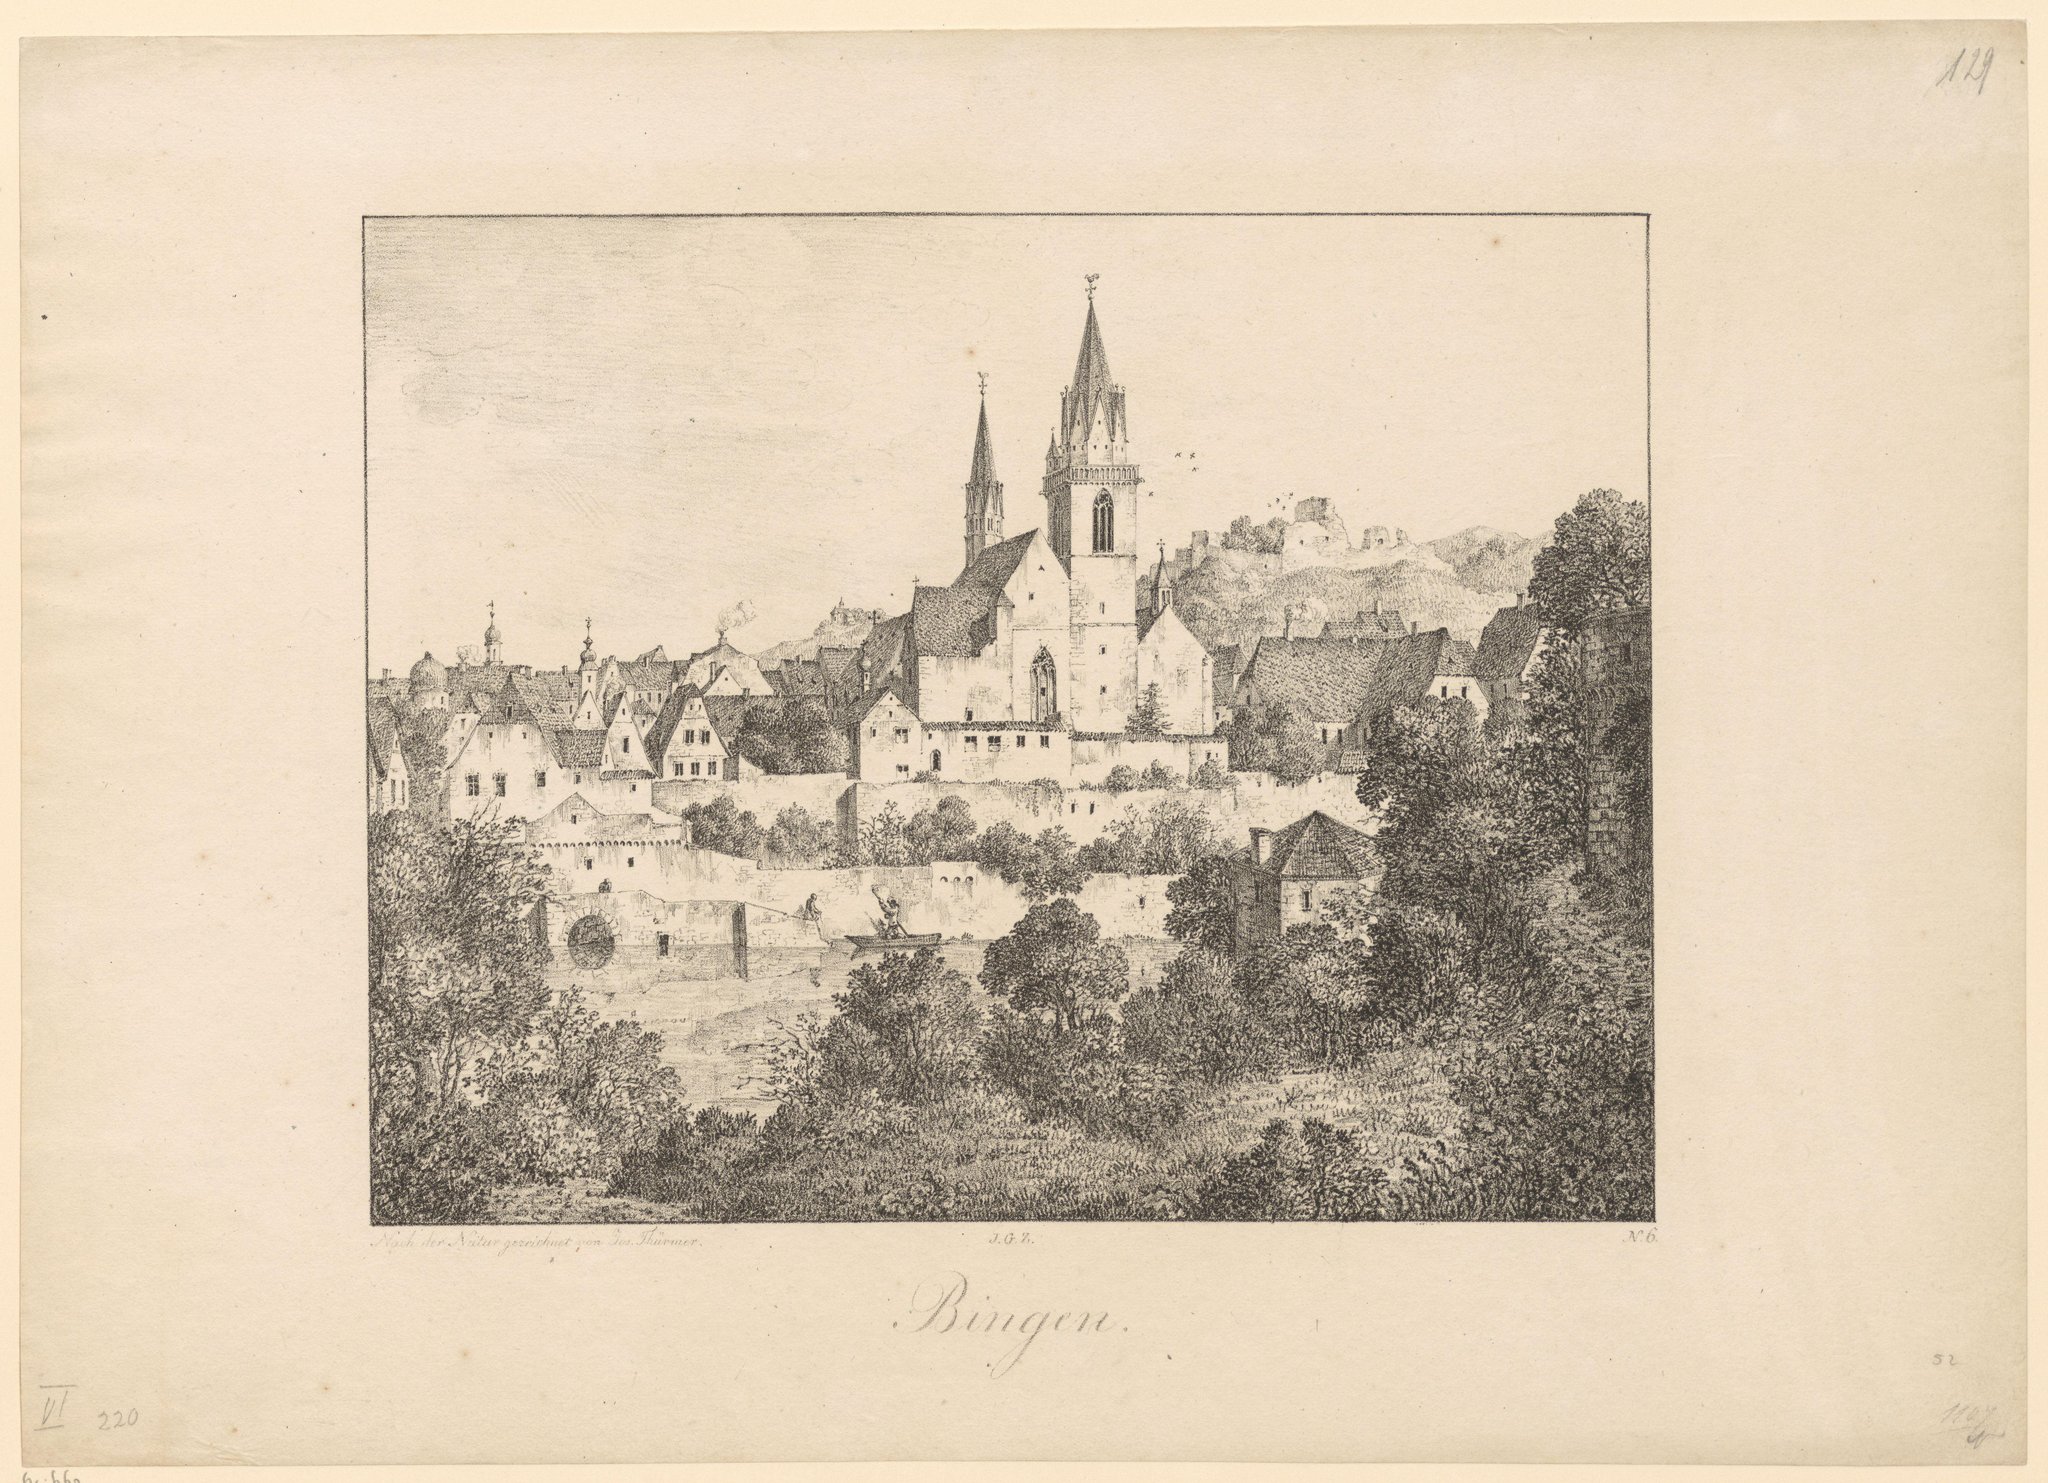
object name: print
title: Gezicht op Bingen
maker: joseph thürmer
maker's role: print maker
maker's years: 1789-1833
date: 1799-1833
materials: paper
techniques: lithograph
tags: church (exterior), city-view, and landscape with man-made constructions (+ city(-scape) with figures, staffage)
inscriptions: collector's mark: Lugt 2228